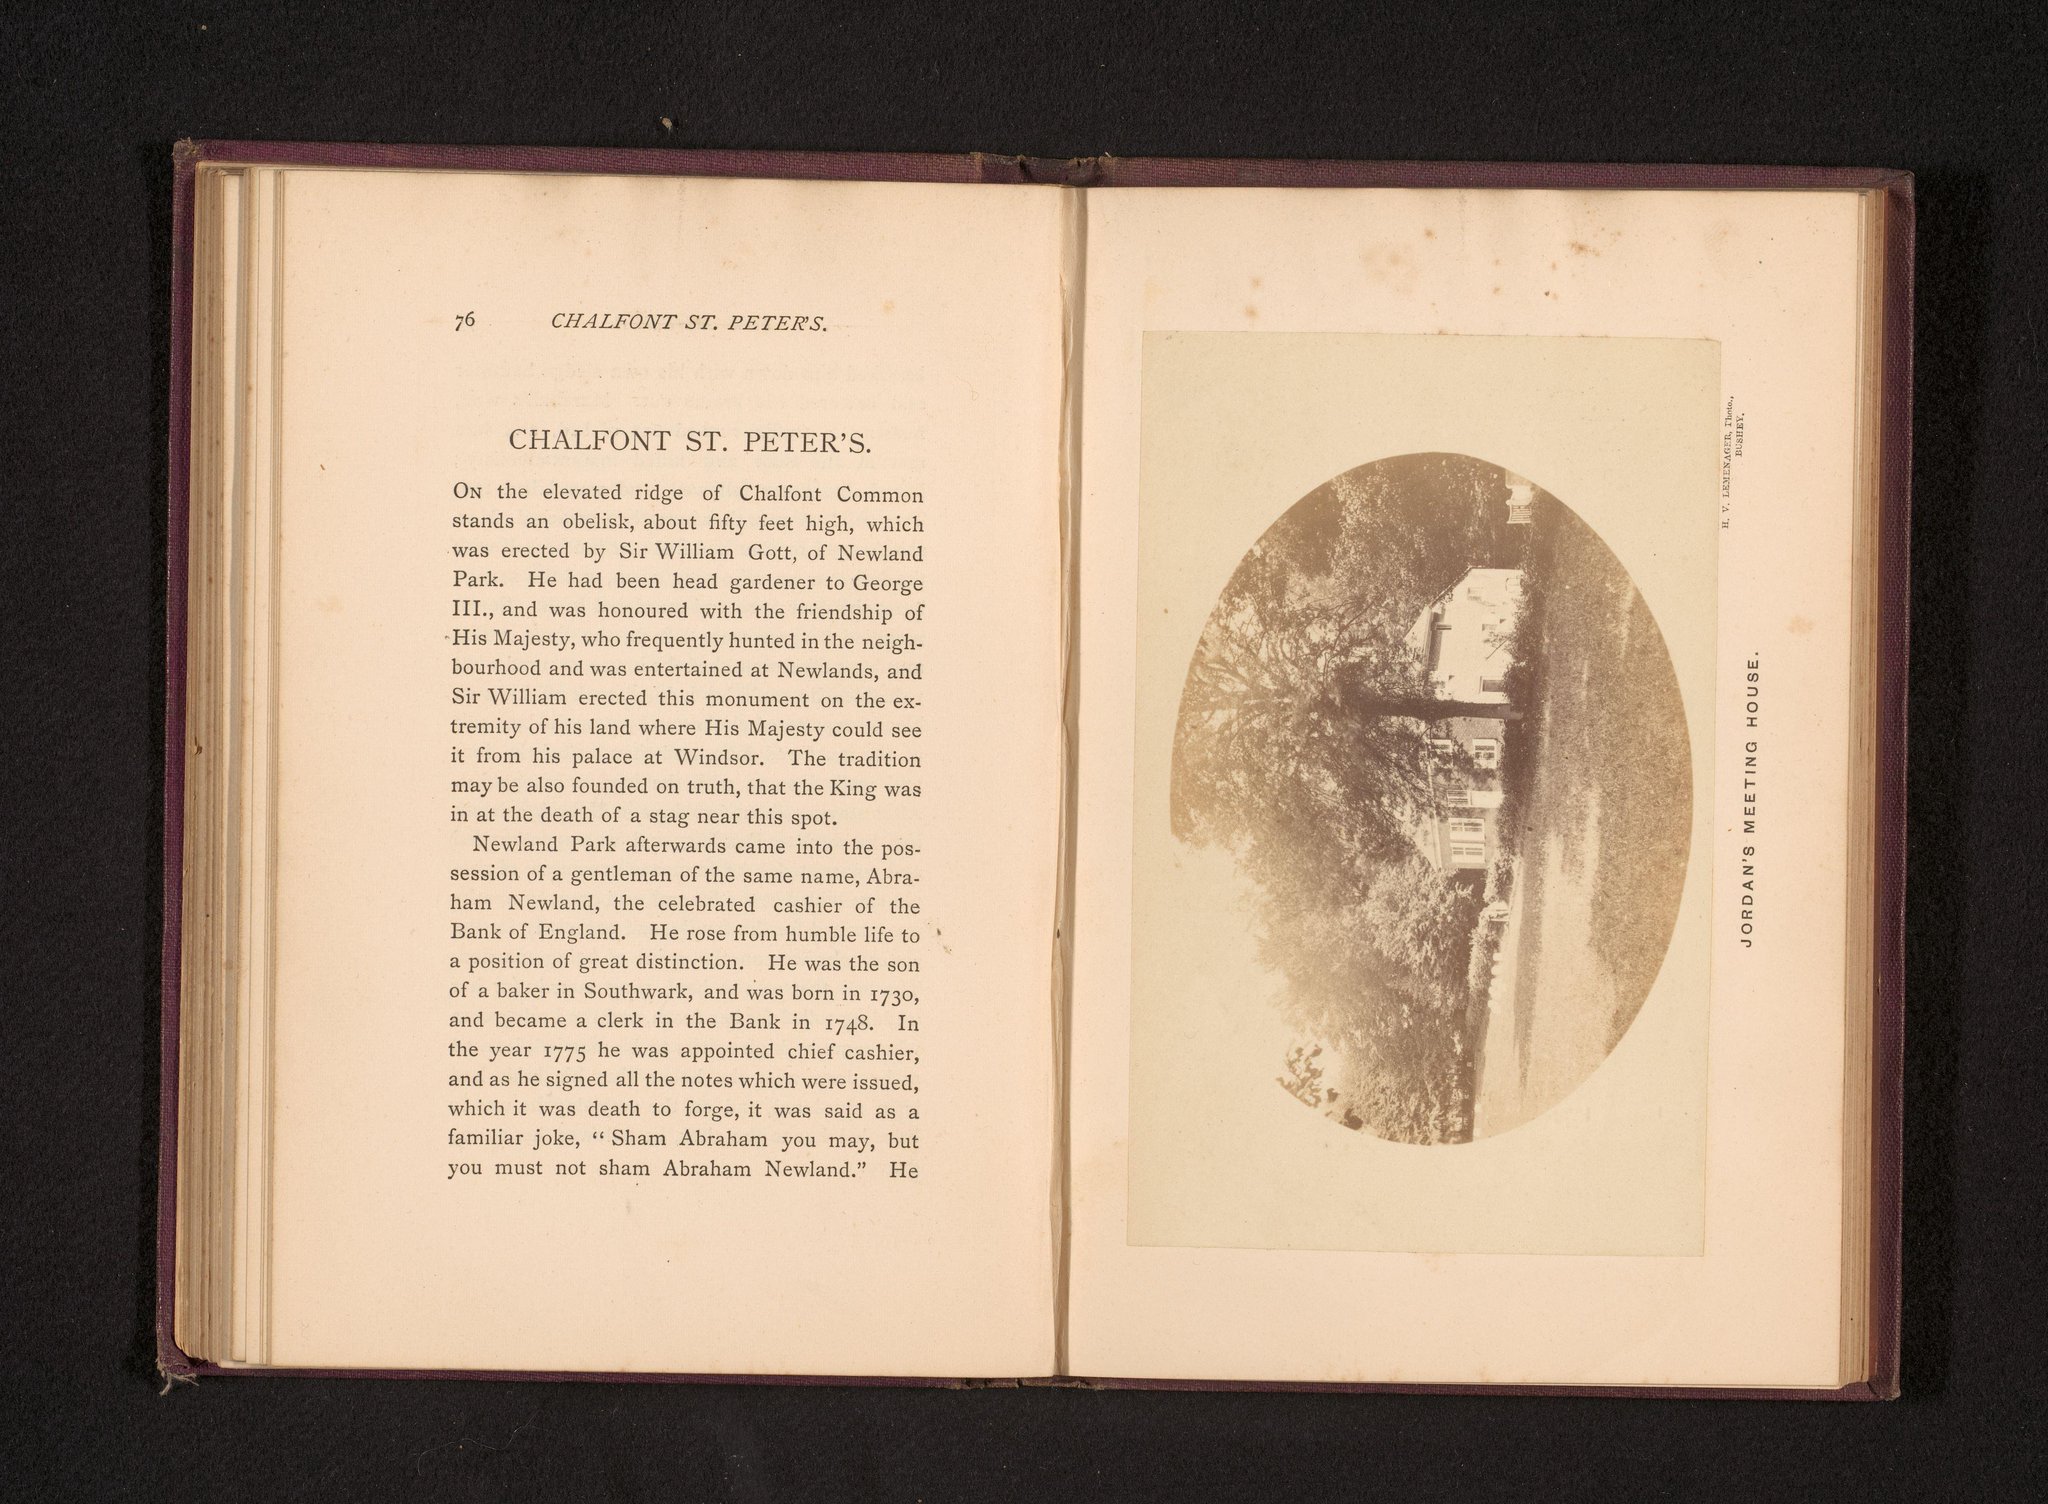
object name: page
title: Gezicht op Jordan's Meeting House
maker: henri victor leménager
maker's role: docent, fotograaf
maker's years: 1822-1912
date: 1865-1870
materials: photographic support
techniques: albumen print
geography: chalfont saint peter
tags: civic architecture; edifices; dwellings